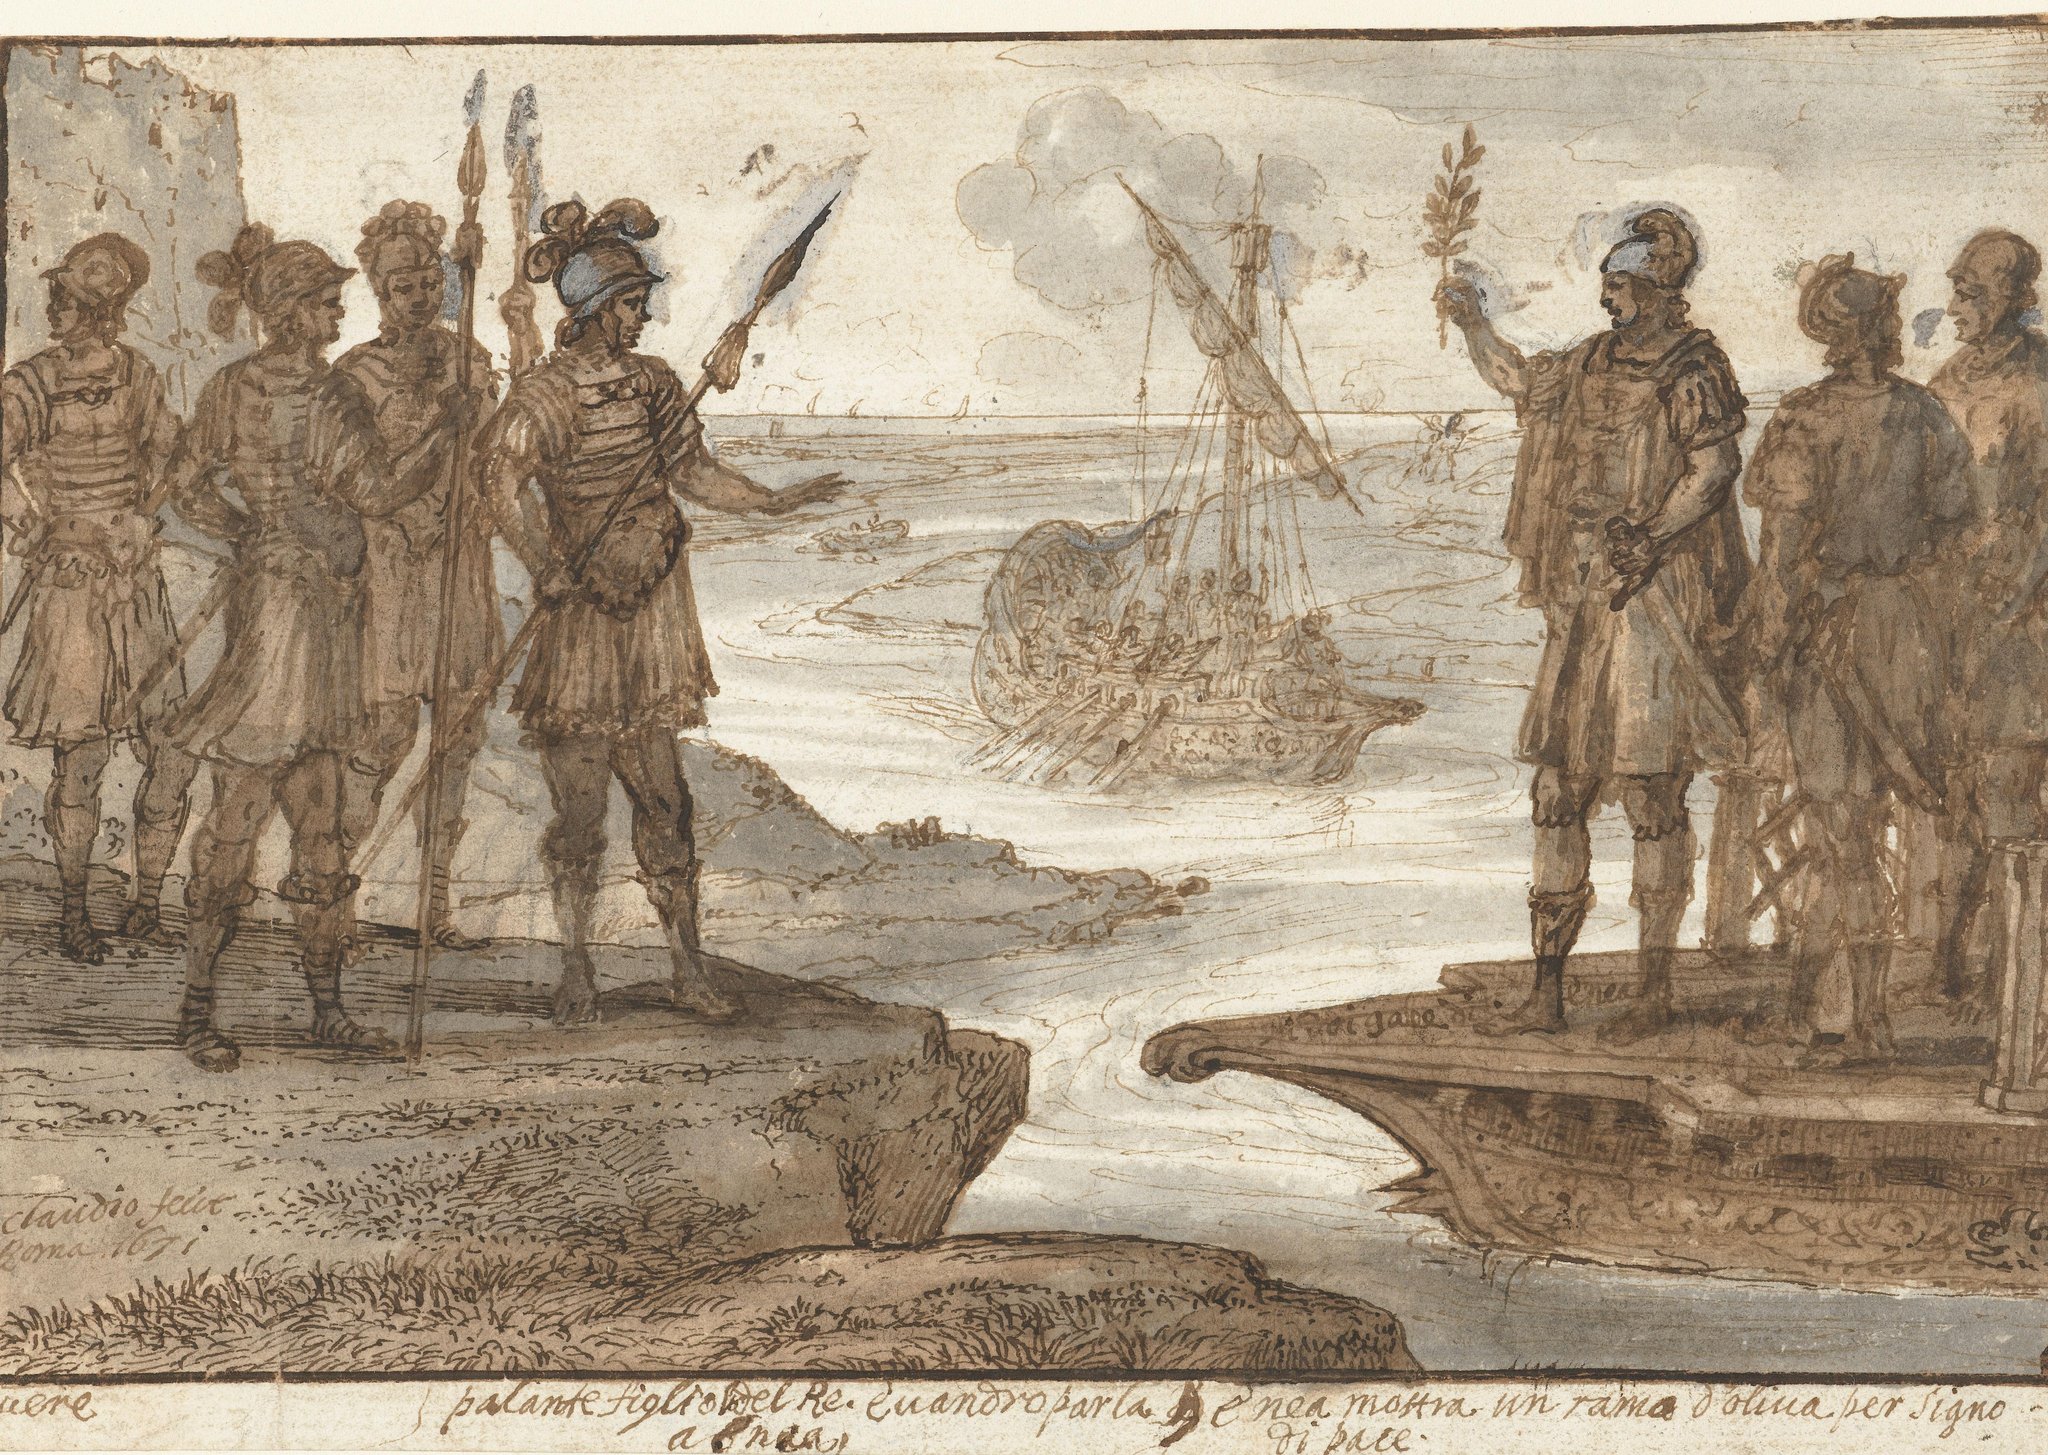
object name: drawing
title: Ontmoeting van Aeneas met Pallas, de zoon van Euander (Evander)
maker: claude lorrain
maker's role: draughtsman, print maker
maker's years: 1604-1682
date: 1671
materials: paper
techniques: brush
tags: arrival of aeneas at pallanteum: while holding out an olive-branch he meets pallas on the shore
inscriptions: date: ‘1671’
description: Voorstudie voor schilderij uit 1672: landschap met de aankomst van Aeneas te Pallantium.